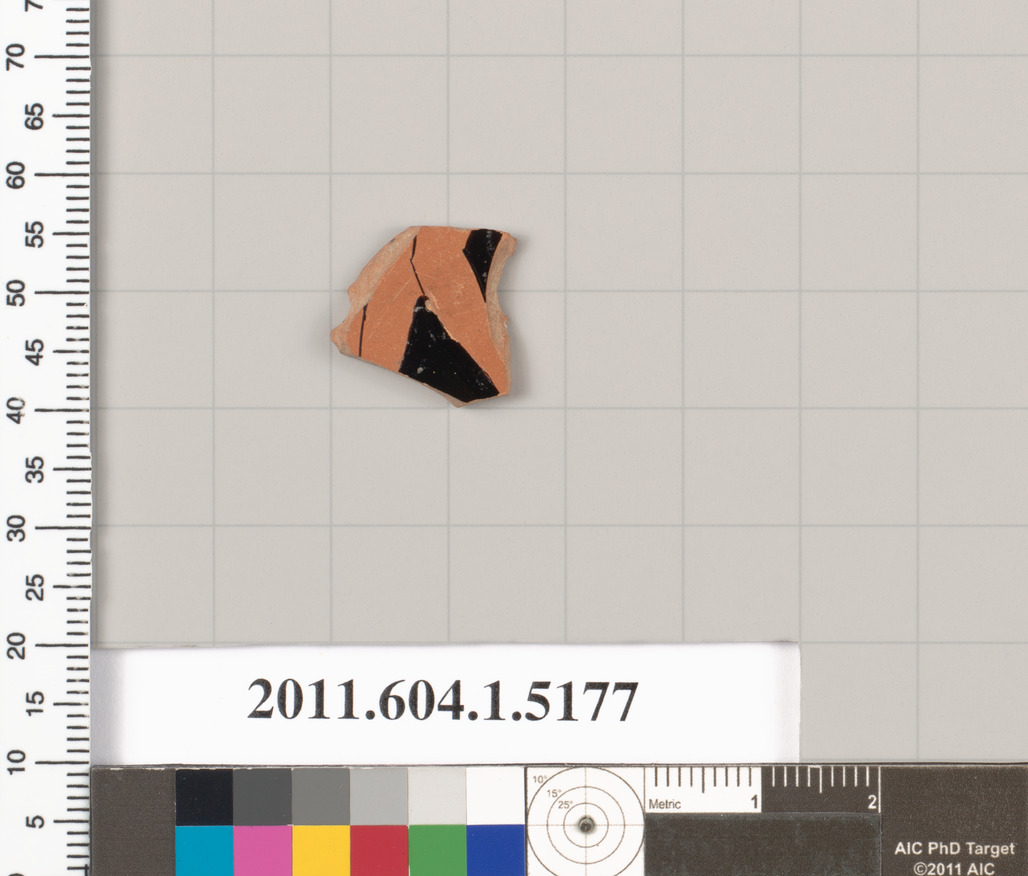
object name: kylix fragment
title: Terracotta fragment of a kylix (drinking cup)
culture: greek, attic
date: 500-480 BCE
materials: terracotta